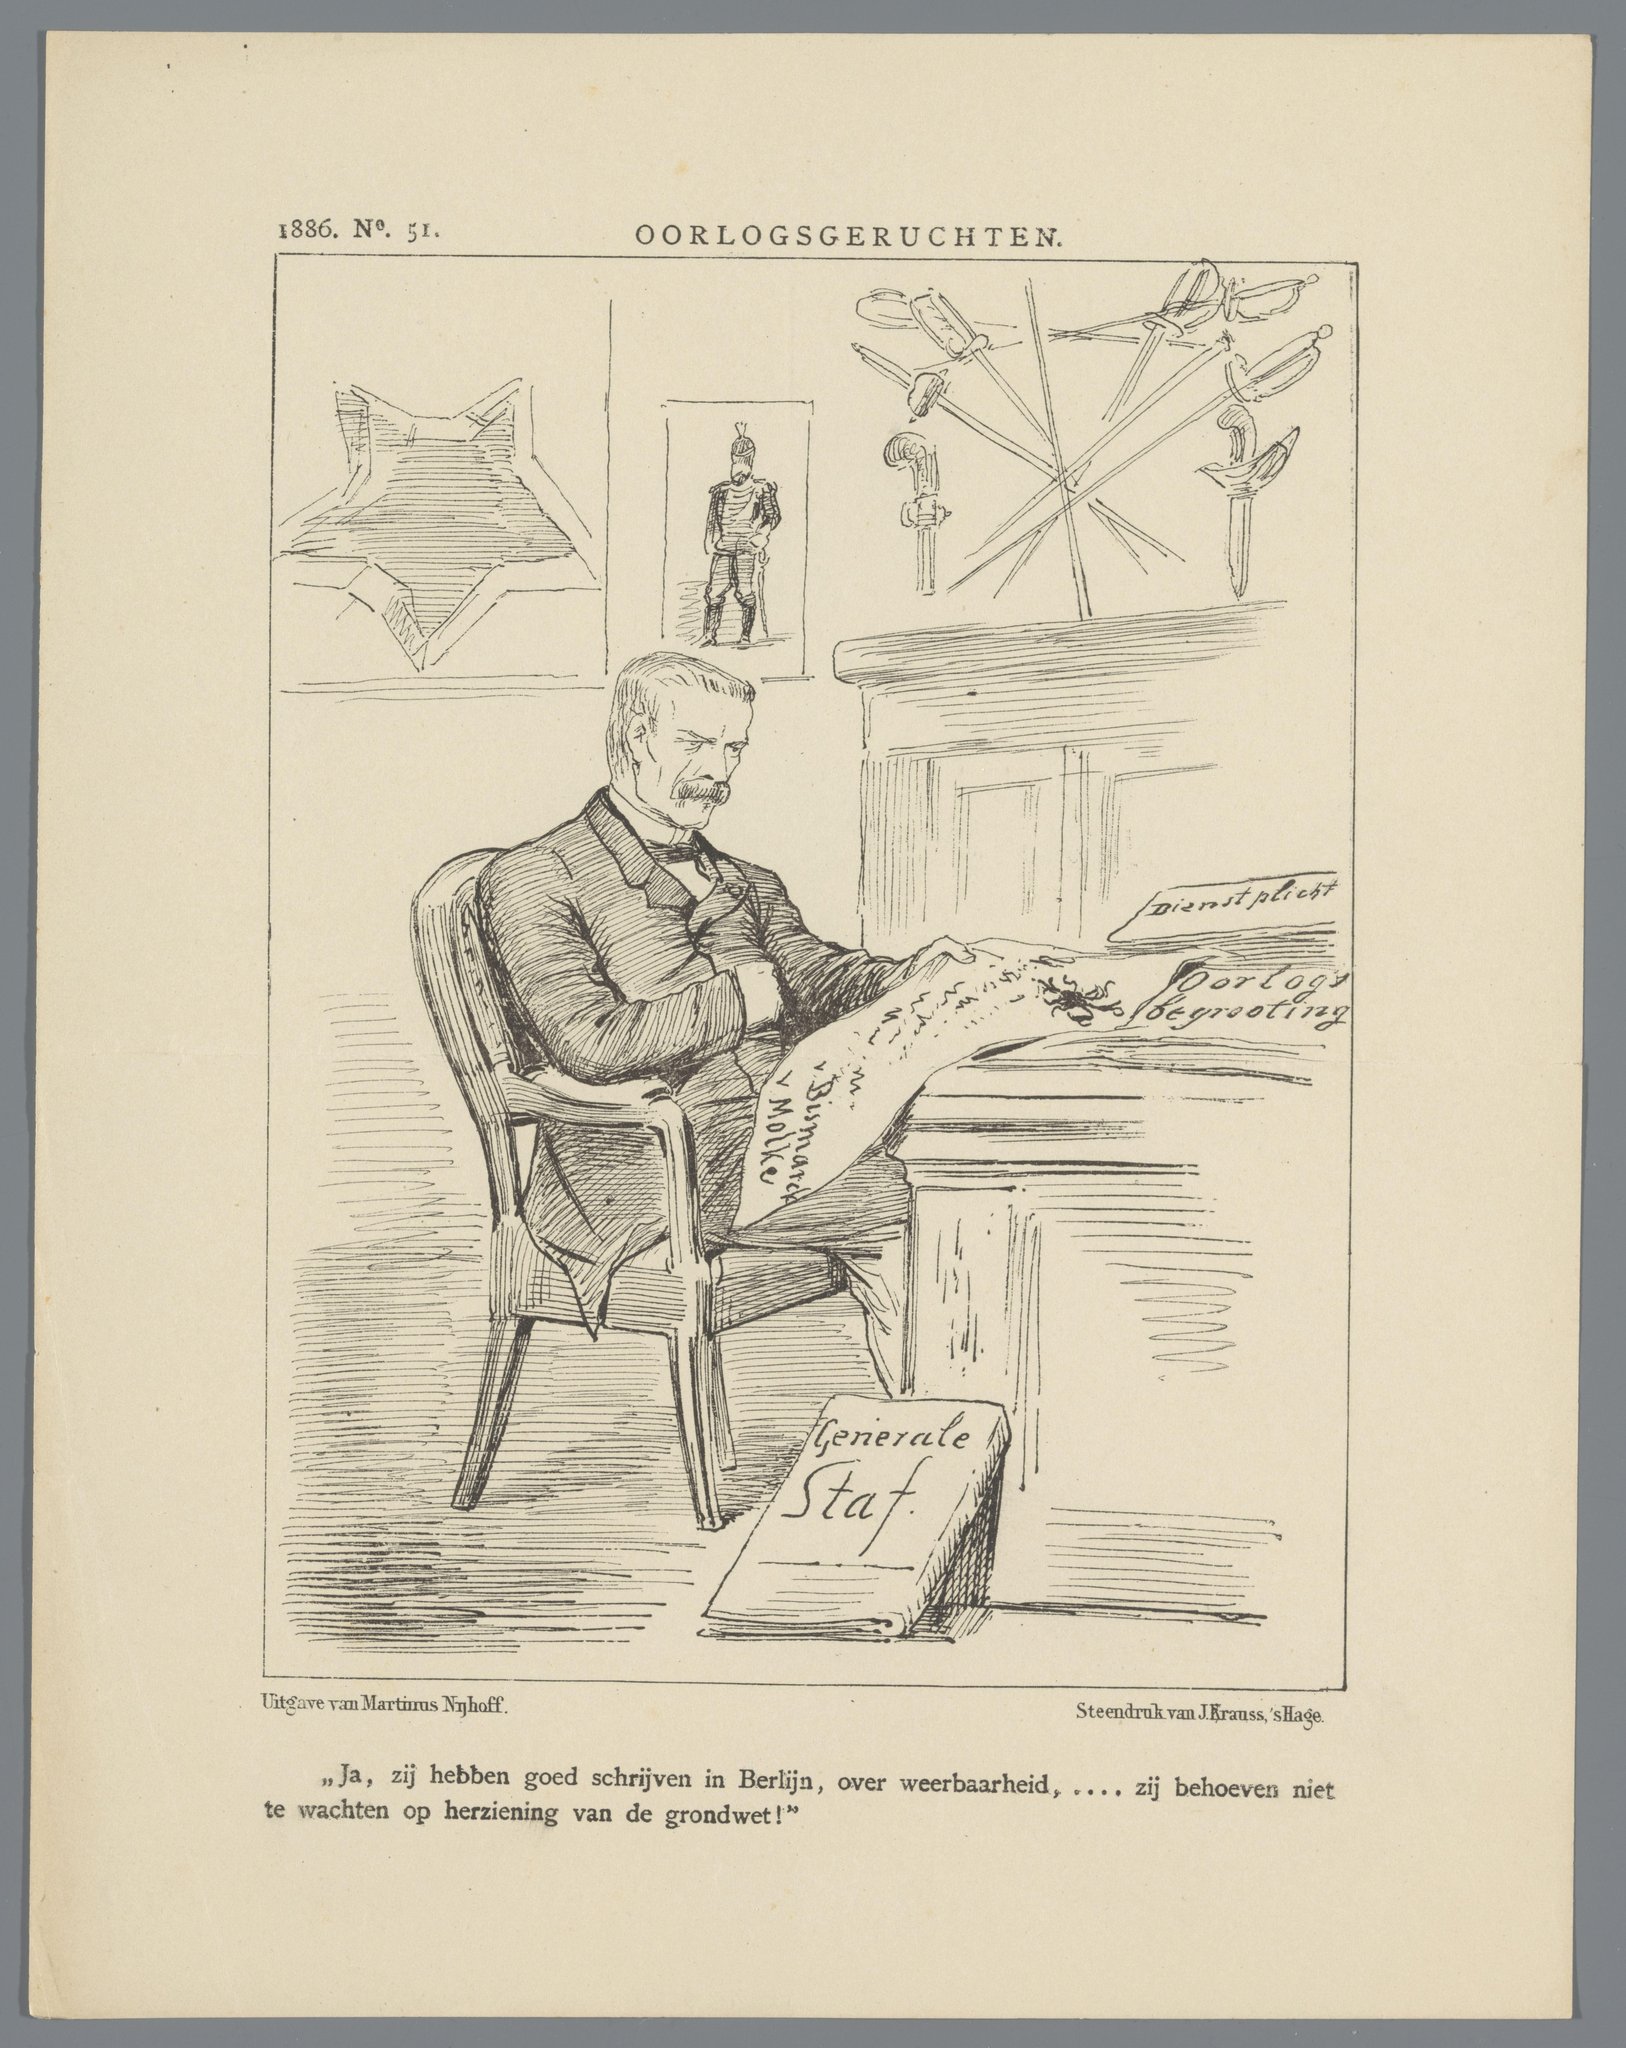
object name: cartoon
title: Spotprent met de Minister van Oorlog, 1886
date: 1886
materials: paper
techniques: lithograph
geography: the hague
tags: ministerie van oorlog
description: Spotprent met de Minister van Oorlog. Plaat verschenen bij het weekblad De Nederlandsche Spectator, nr. 51, 1886.